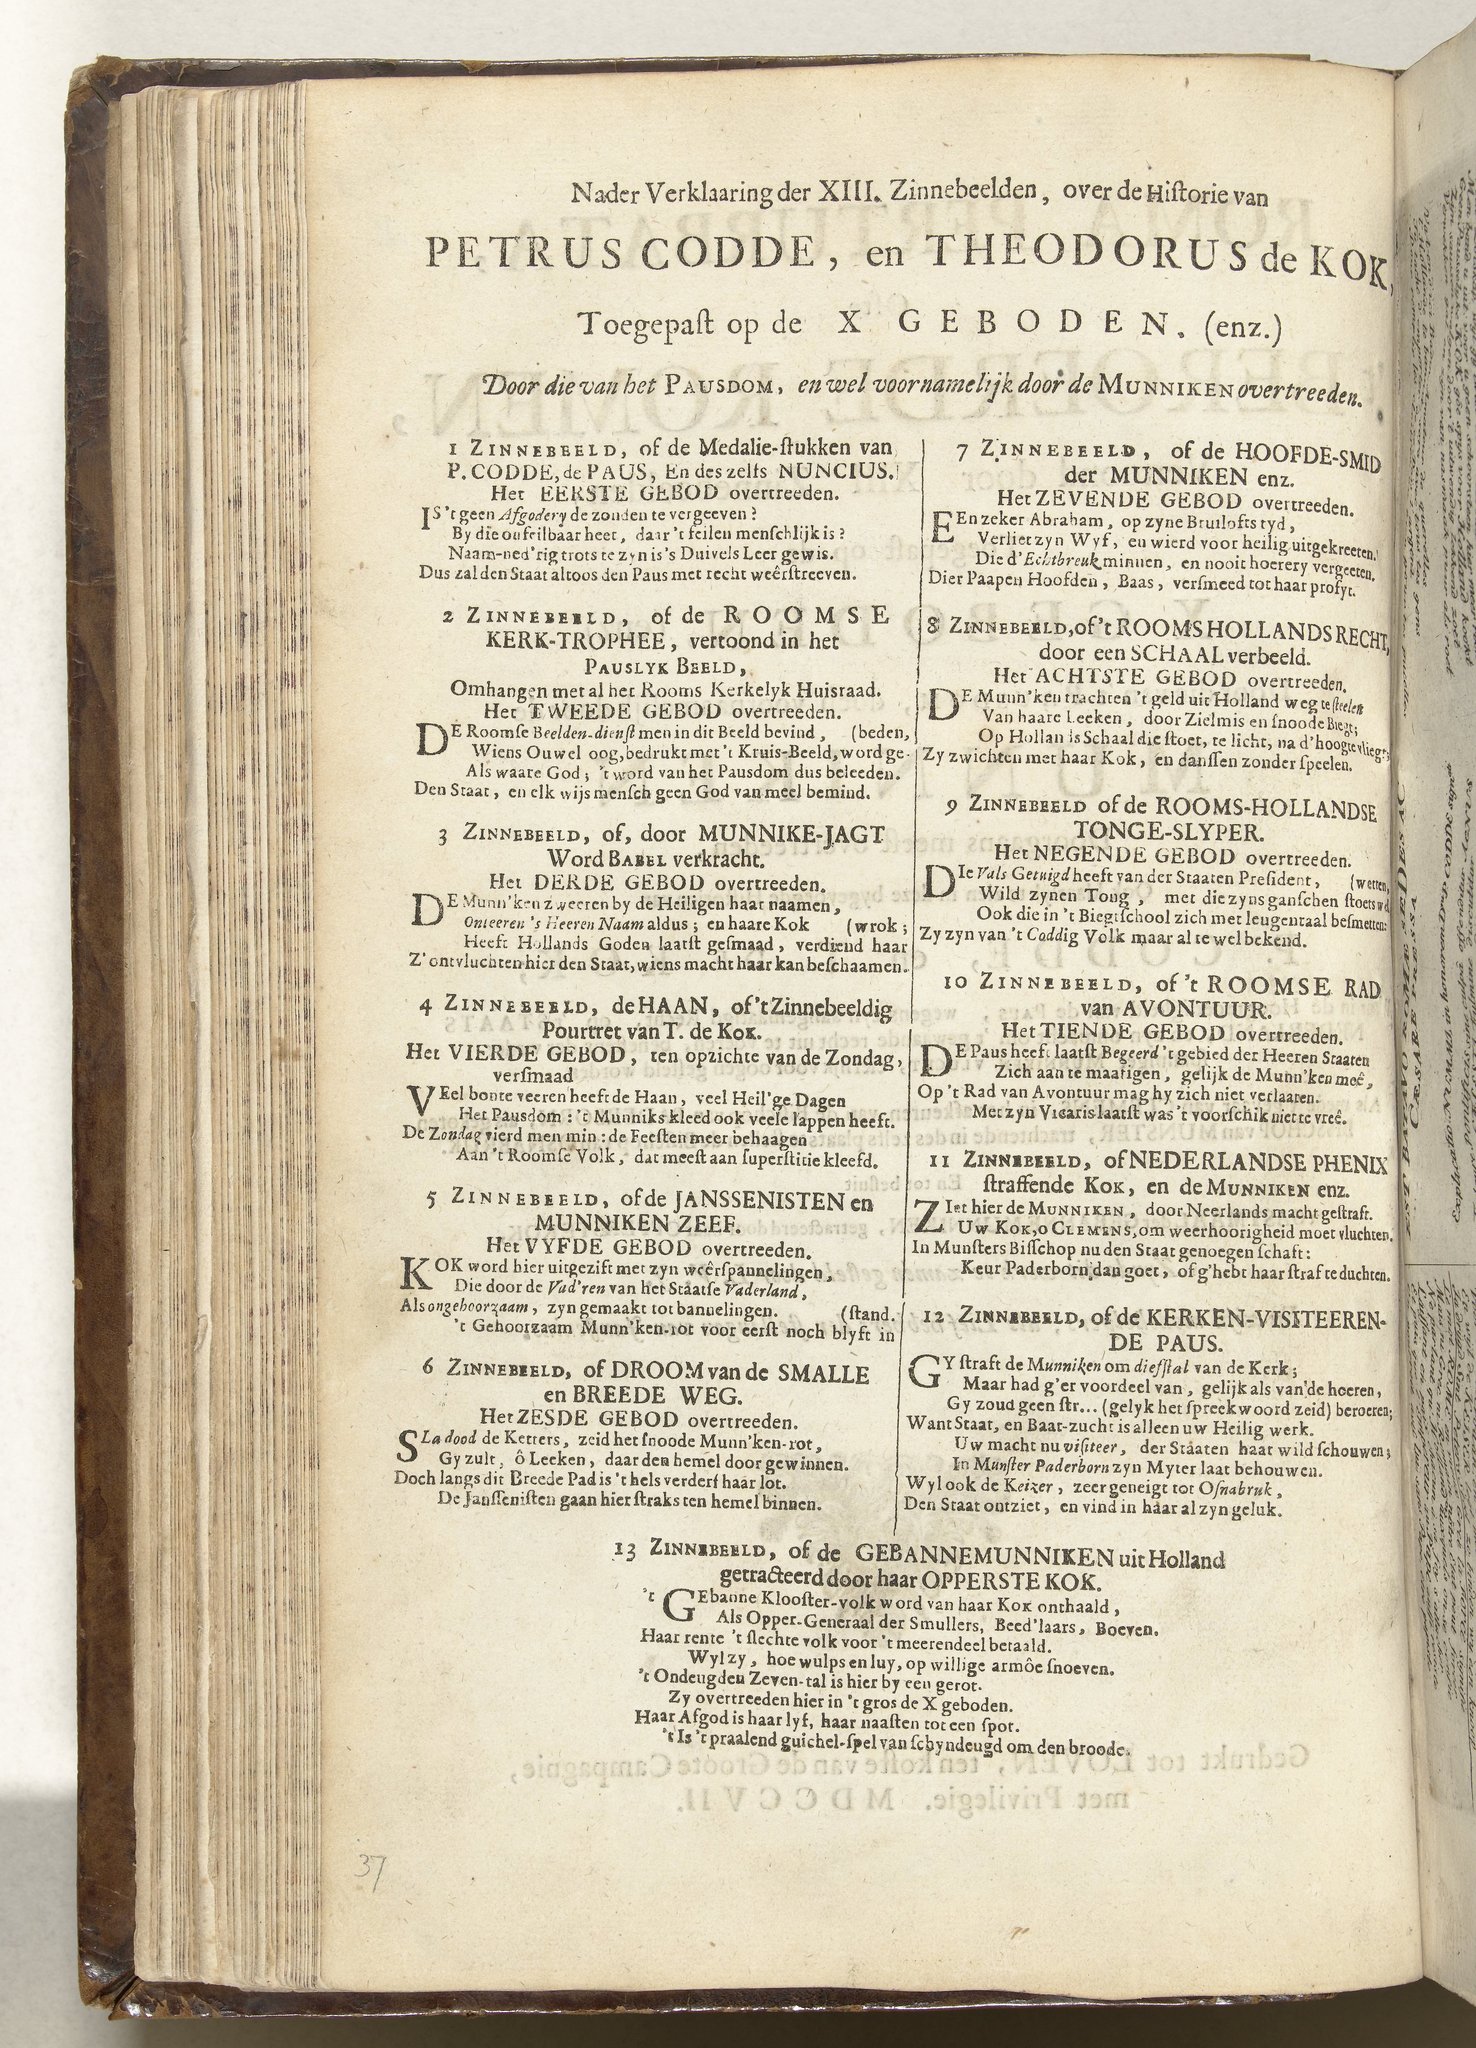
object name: table of content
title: Nader Verklaaring der XIII. Zinnebeelden, over de Historie van Petrus Codde, en Theodorus de Kok, Toegepast op de X Geboden. (enz.)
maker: carel allard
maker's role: print maker, publisher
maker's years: 1648-1709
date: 1706-1707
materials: paper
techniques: letterpress printing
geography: amsterdam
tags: utrecht, rome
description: Inhoudsopgave voor de serie Roma Pertubata van 1706, in de nieuwe vermeerderde uitgave van 1707. Twee kolommen met een vers voor elk van de 13 spotprenten op de twisten in 1705 tussen de jezuïeten en de jansenisten in de Republiek. Onderdeel van het prentwerk uitgegeven onder de verzameltitel 't Lust-Hof van Momus met de gebundelde series van spotprenten tijdens de jaren 1701-1713 van de Spaanse Successieoorlog.